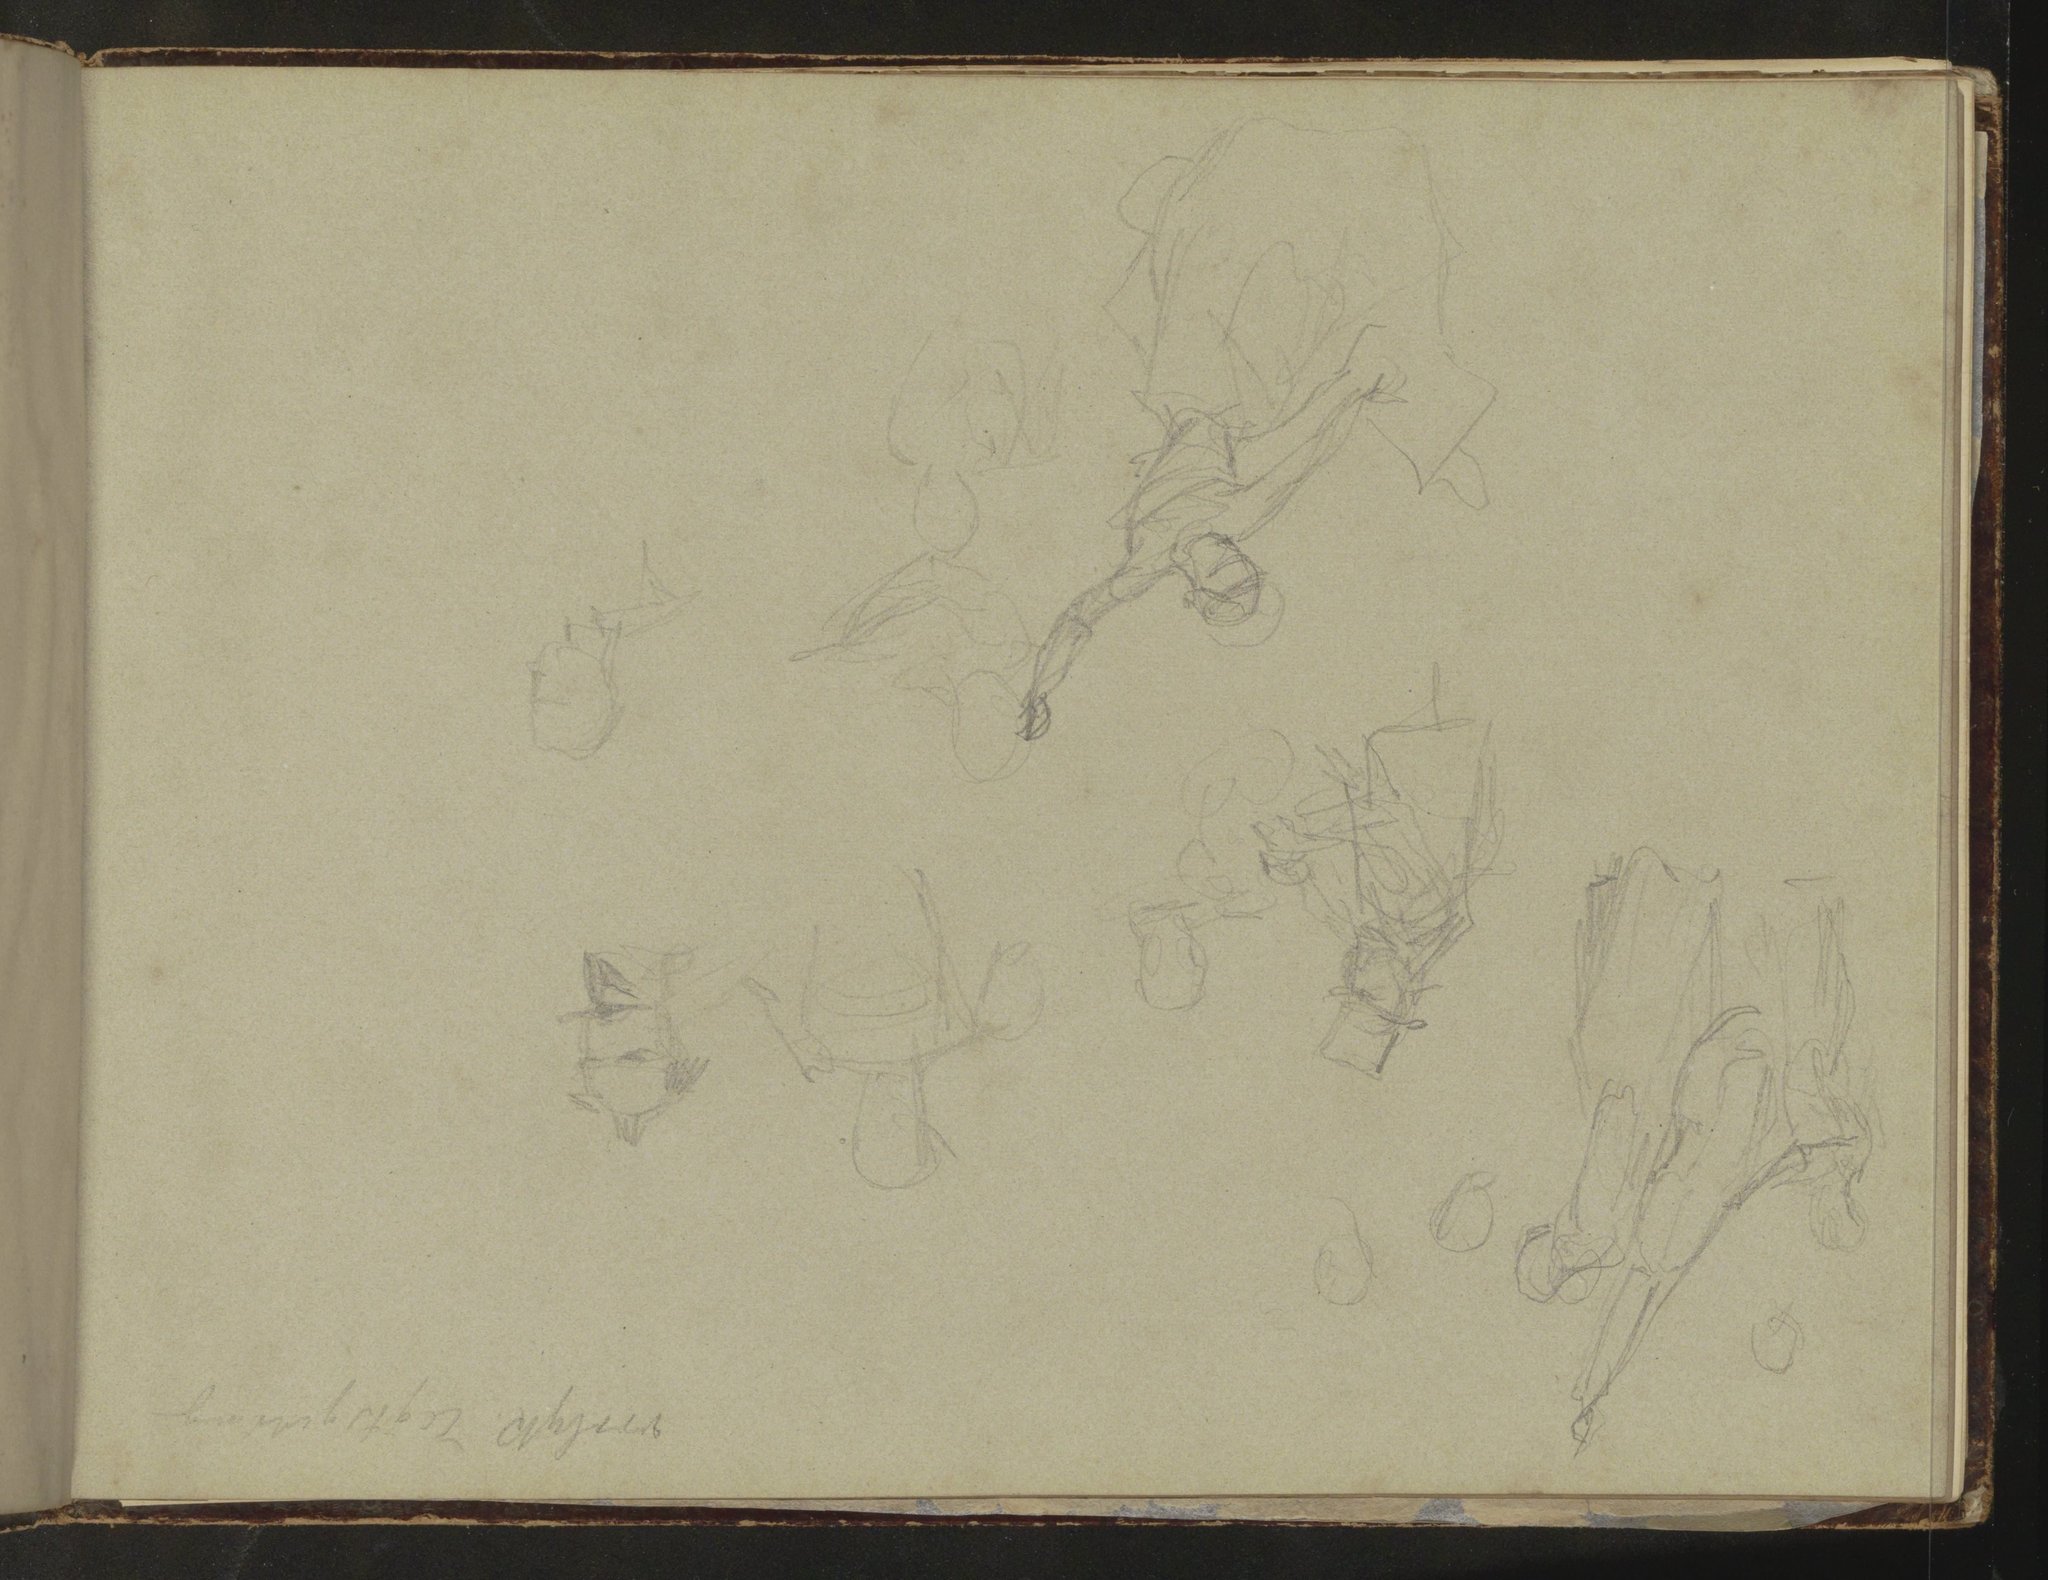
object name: sketchbook leaf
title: Studieblad met vaandeldragers en een dansende vrouw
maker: reinier craeyvanger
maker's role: draughtsman, print maker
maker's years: 1812-1880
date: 1822-1880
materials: paper, pencil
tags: head (human), woman dancing alone, standard-bearer, flag-bearer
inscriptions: annotation: ‘vrolijk regtsgedrag’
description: Tevens studies van koppen en een man met een hoge hoed. Blad 8 recto uit een schetsboek met 45 bladen.